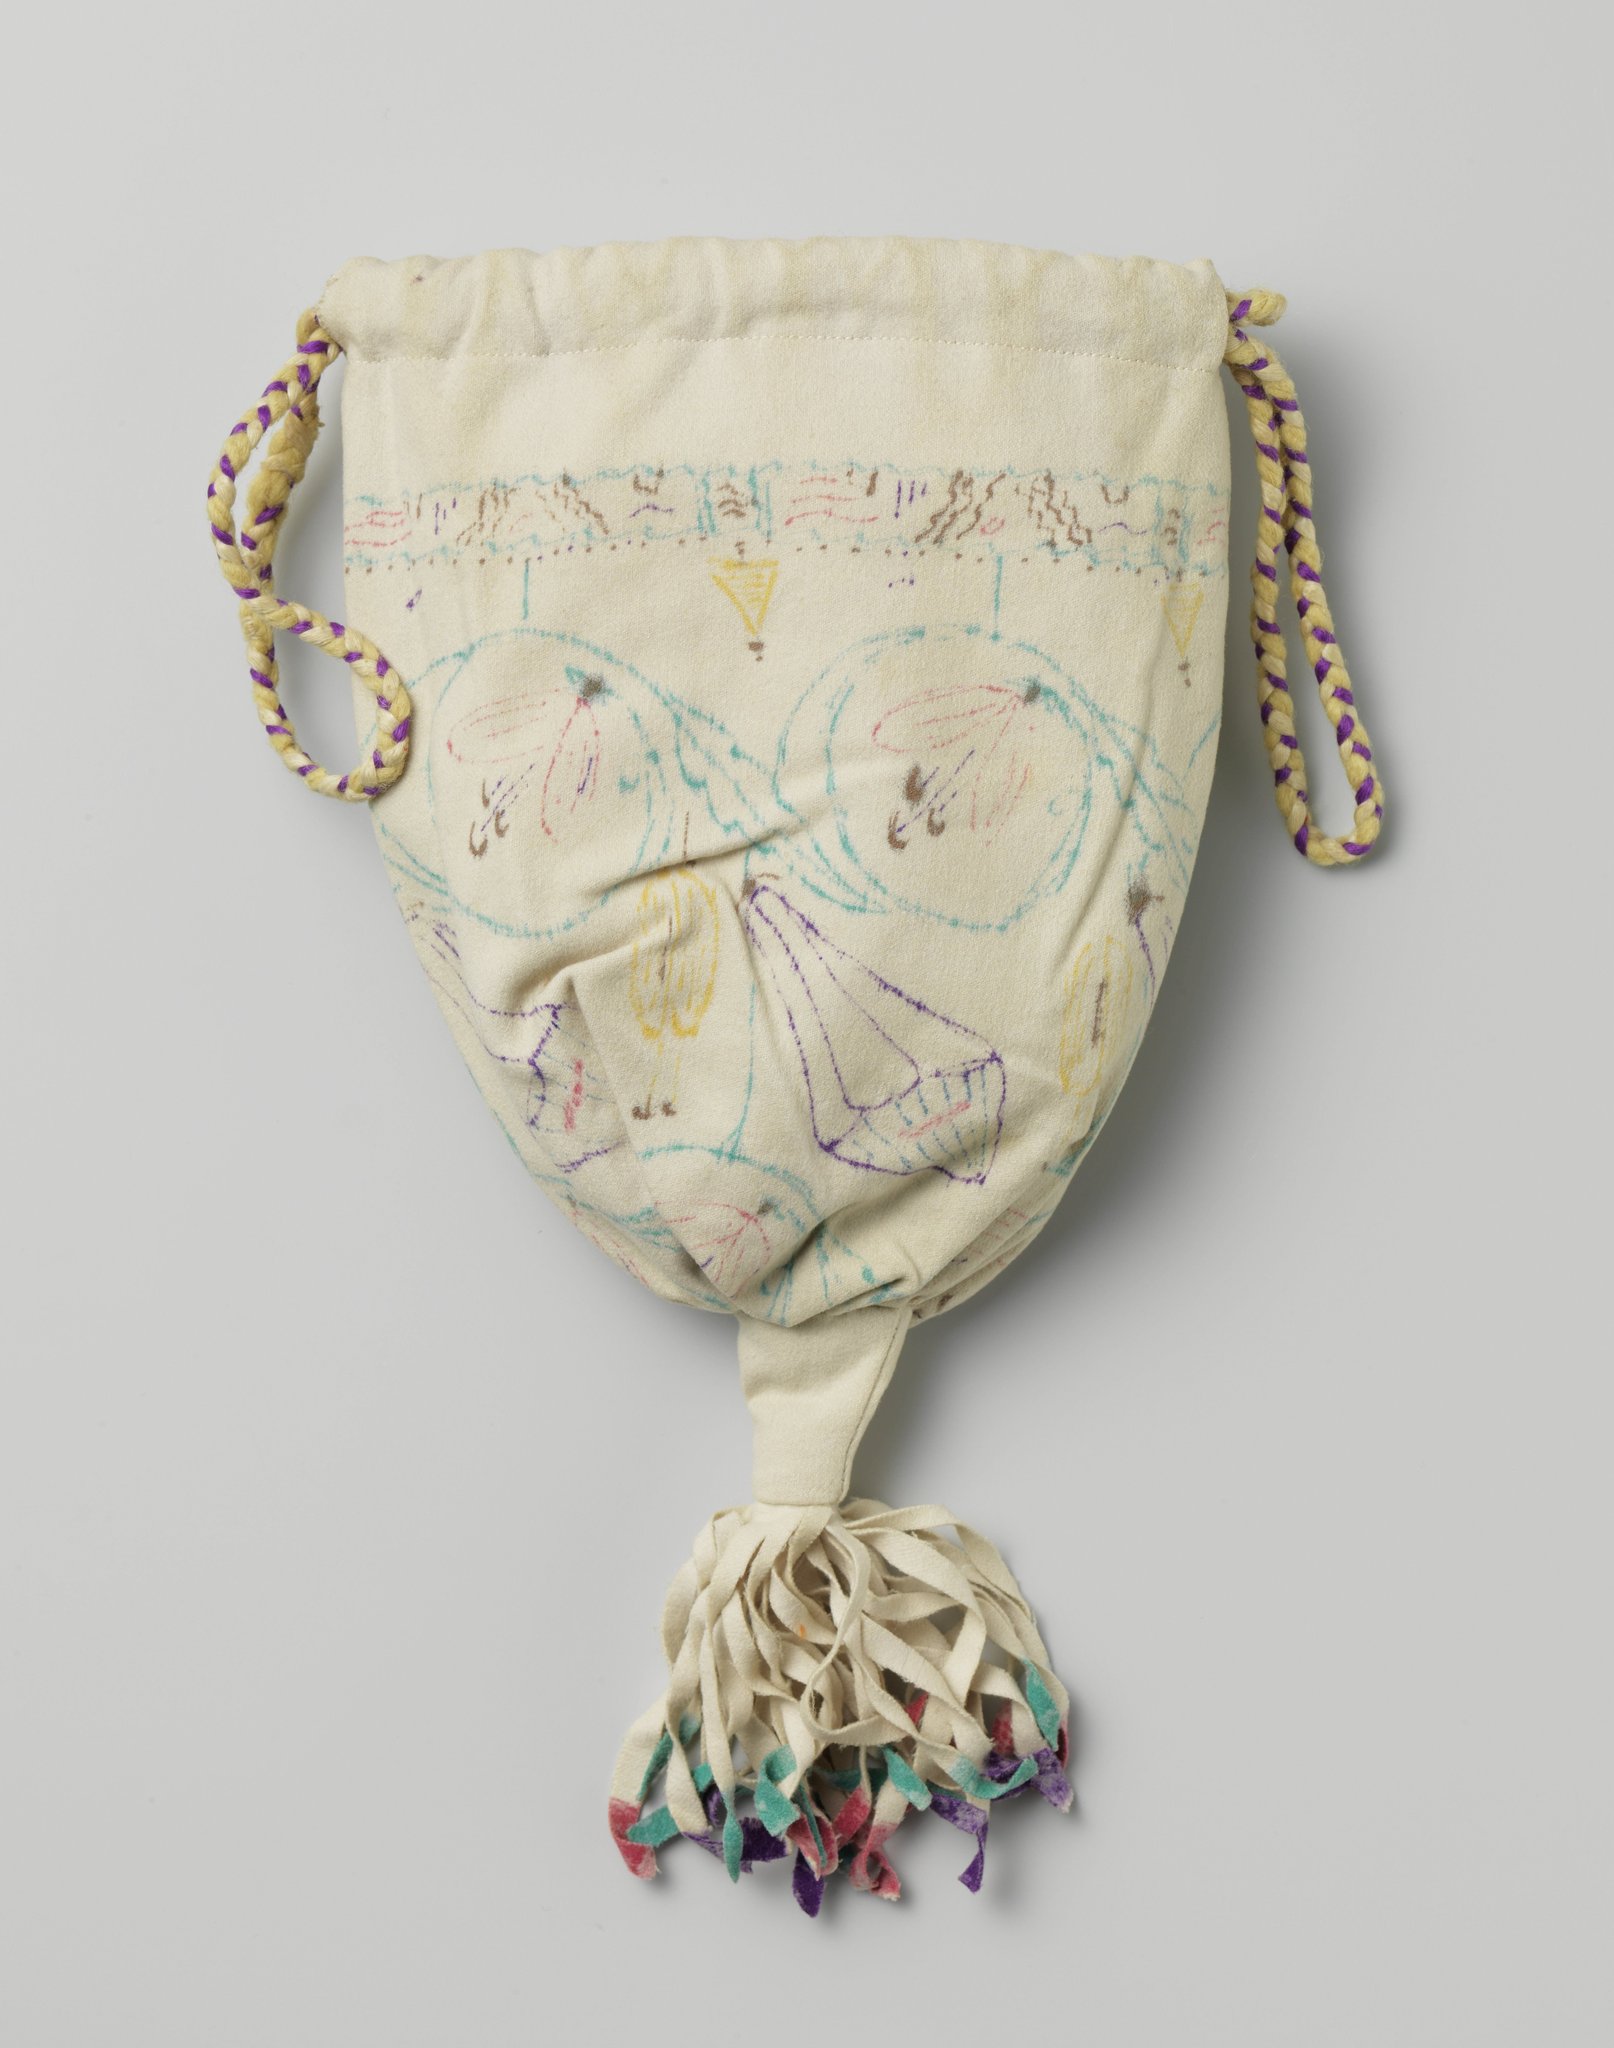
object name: purse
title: Buidel van ecrukleurige wollen stof, versierd met een veelkleurige non-figuratieve contouren in (vilt)stift, onderaan een kwast met groene, roze en paarse uiteinden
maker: Anonymous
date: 1900-1925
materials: cotton, silk, wool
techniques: braiding, drawing, felted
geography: netherlands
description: Buidel van ecrukleurige wollen stof, versierd met een veelkleurige non-figuratieve contouren in (vilt)stift. De stof heeft langs een naad en is onderaan samengeregen, waaraan een onversierde strook en een kwast van dezelfde wollen stof, met groen, roze en paars gekleurde uiteinden. Met een gevlochten koord van paarse zijde, gele wol en beige katoen, die door een een tunnel langs de bovenrand geregen is. De tas is ongevoerd.